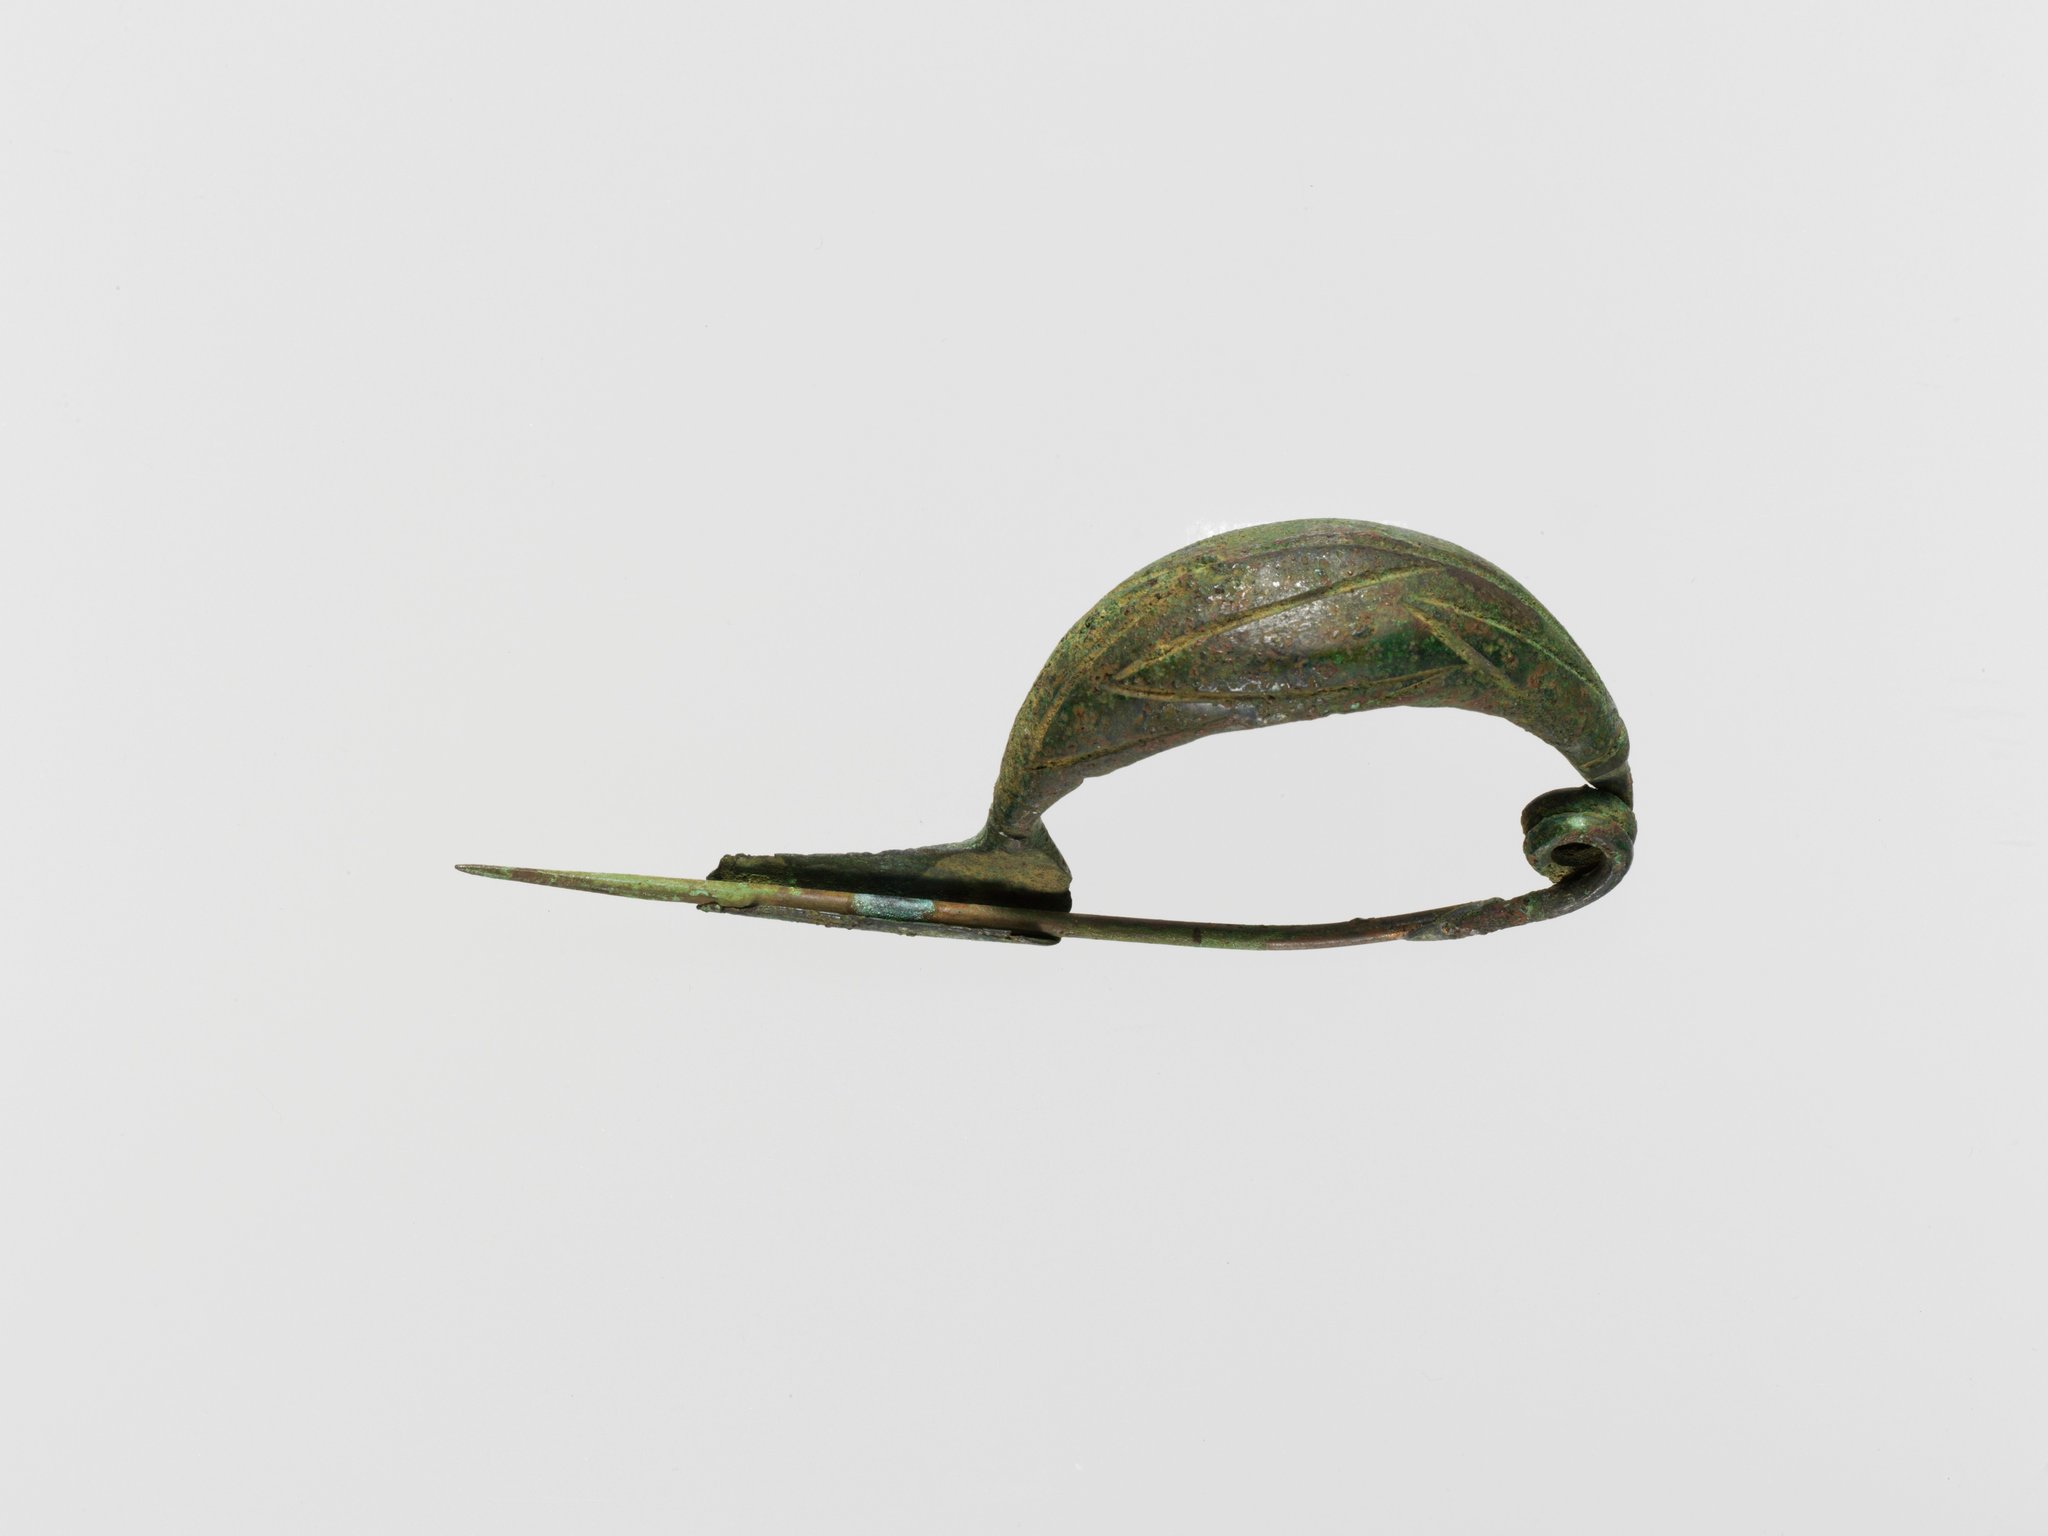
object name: fibula, boat shaped type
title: Bronze sanguisuga-type fibula (safety pin)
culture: etruscan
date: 710-675 BCE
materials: bronze